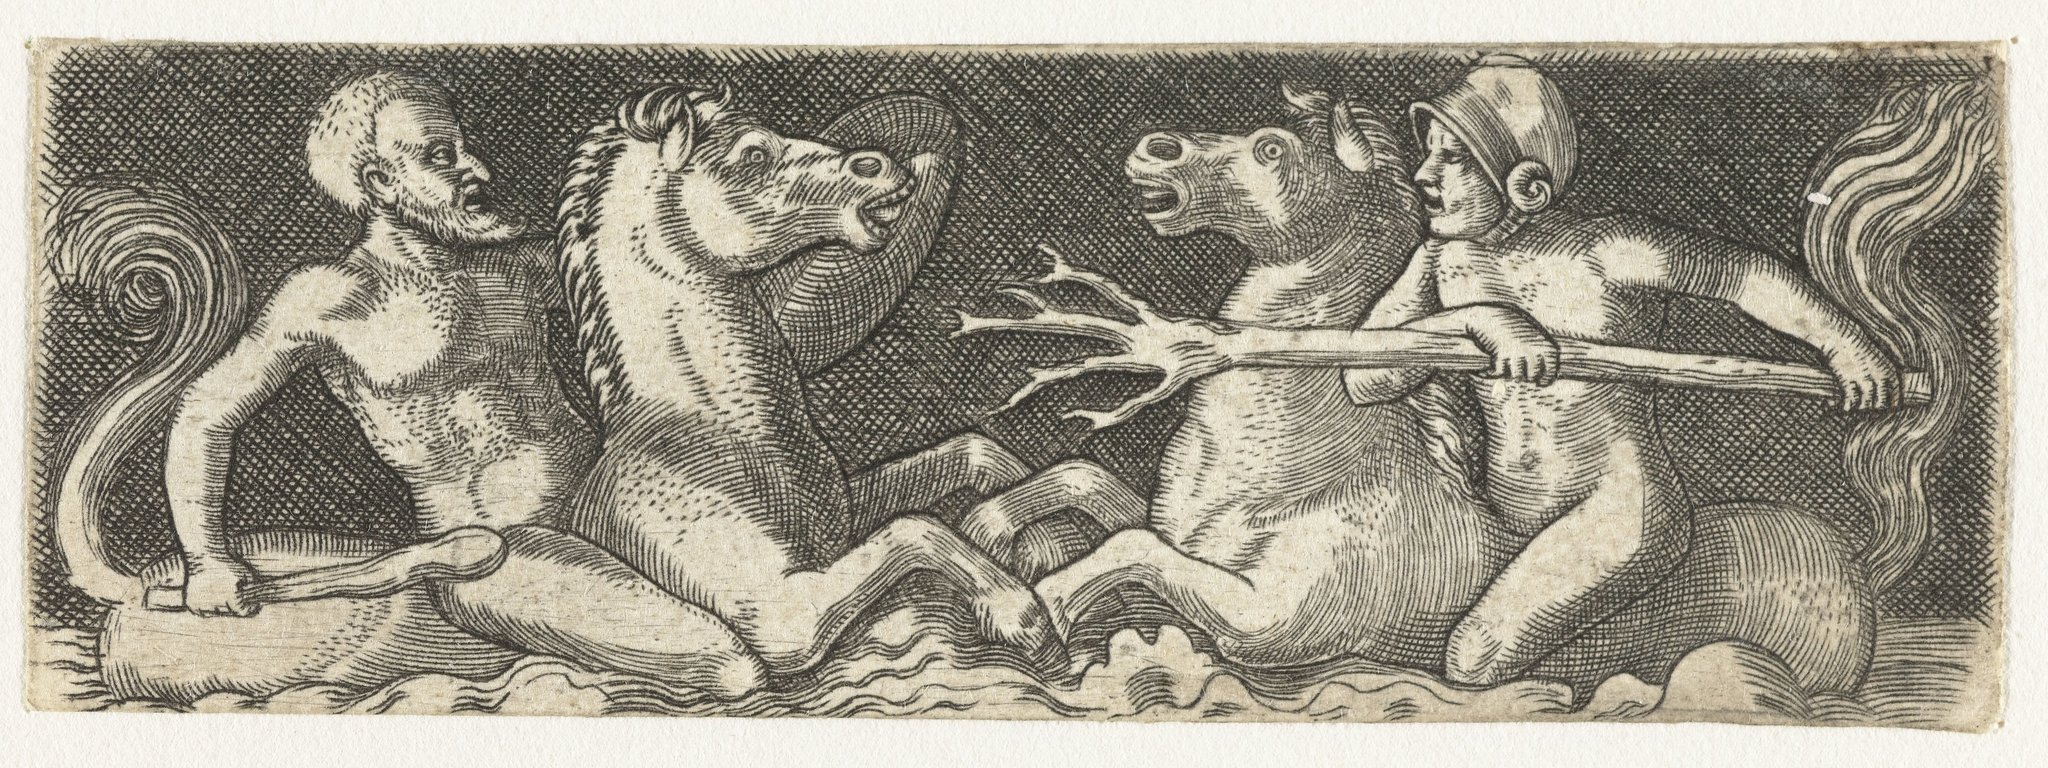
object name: print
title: Twee strijdende tritons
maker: Anonymous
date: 1512-1590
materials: paper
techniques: engraving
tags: triton(s)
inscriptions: collector's mark: Lugt 240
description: Kopie in spiegelbeeld naar een prent van Barthel Beham